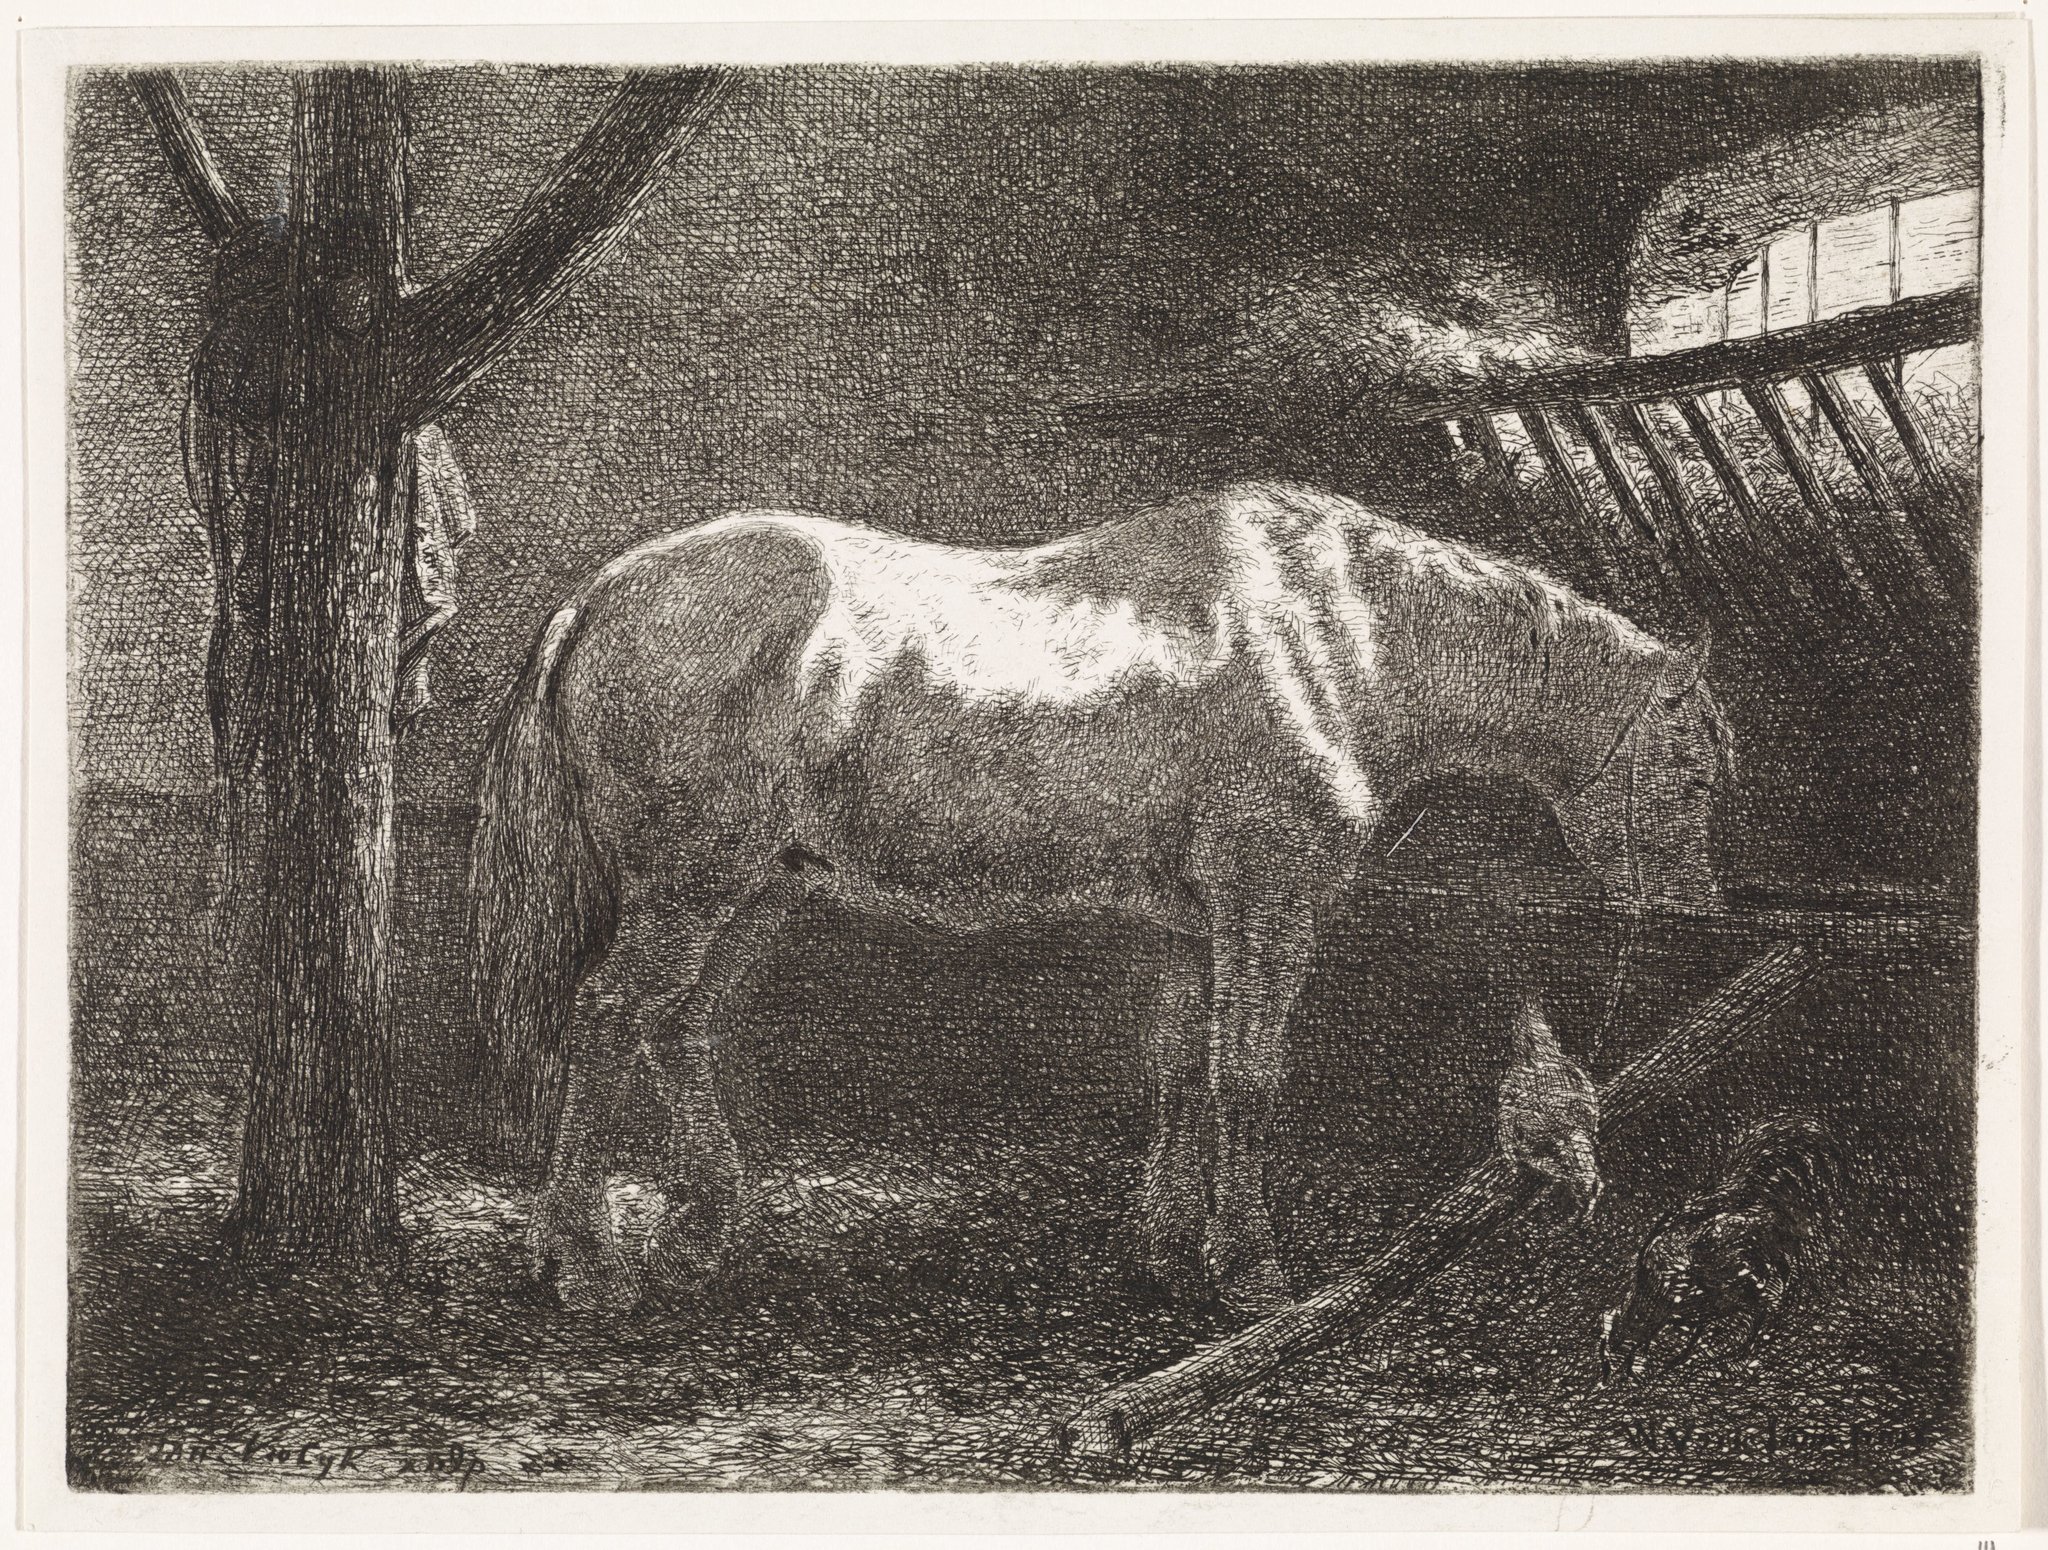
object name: print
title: Paard in stal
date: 1860-1894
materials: paper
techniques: etching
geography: the hague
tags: horses and kindred animals, fowl (cock, hen, chicken, etc.), stall, stable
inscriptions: collector's mark: Lugt 2228